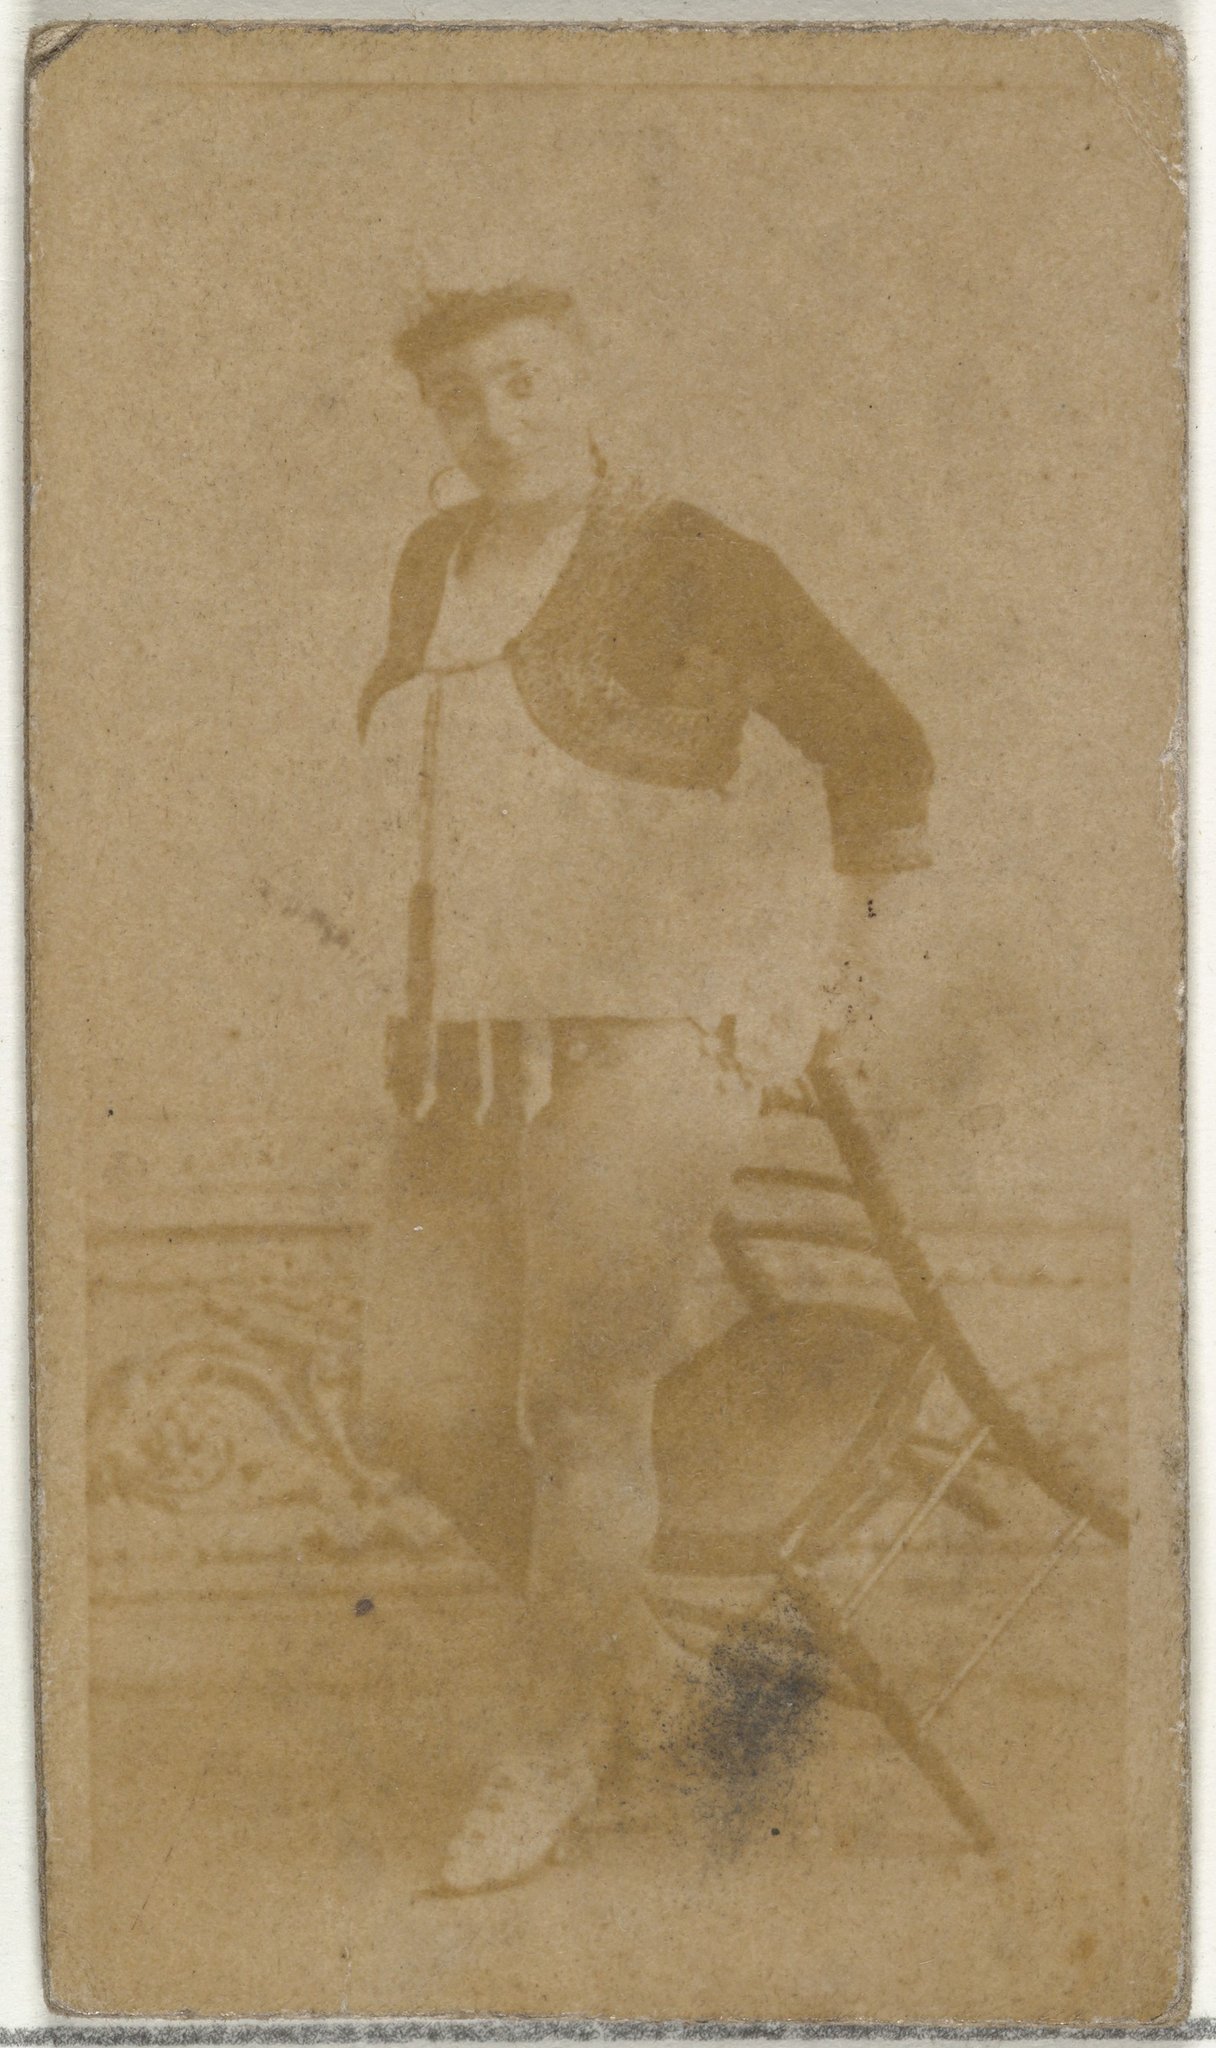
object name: photograph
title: [Actress tipping chair], from the Actors and Actresses series (N145-8) issued by Duke Sons & Co. to promote Duke Cigarettes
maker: w. duke, sons & co.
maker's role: publisher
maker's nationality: american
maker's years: 1870-1920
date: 1891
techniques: albumen silver print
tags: portraits,women,actresses